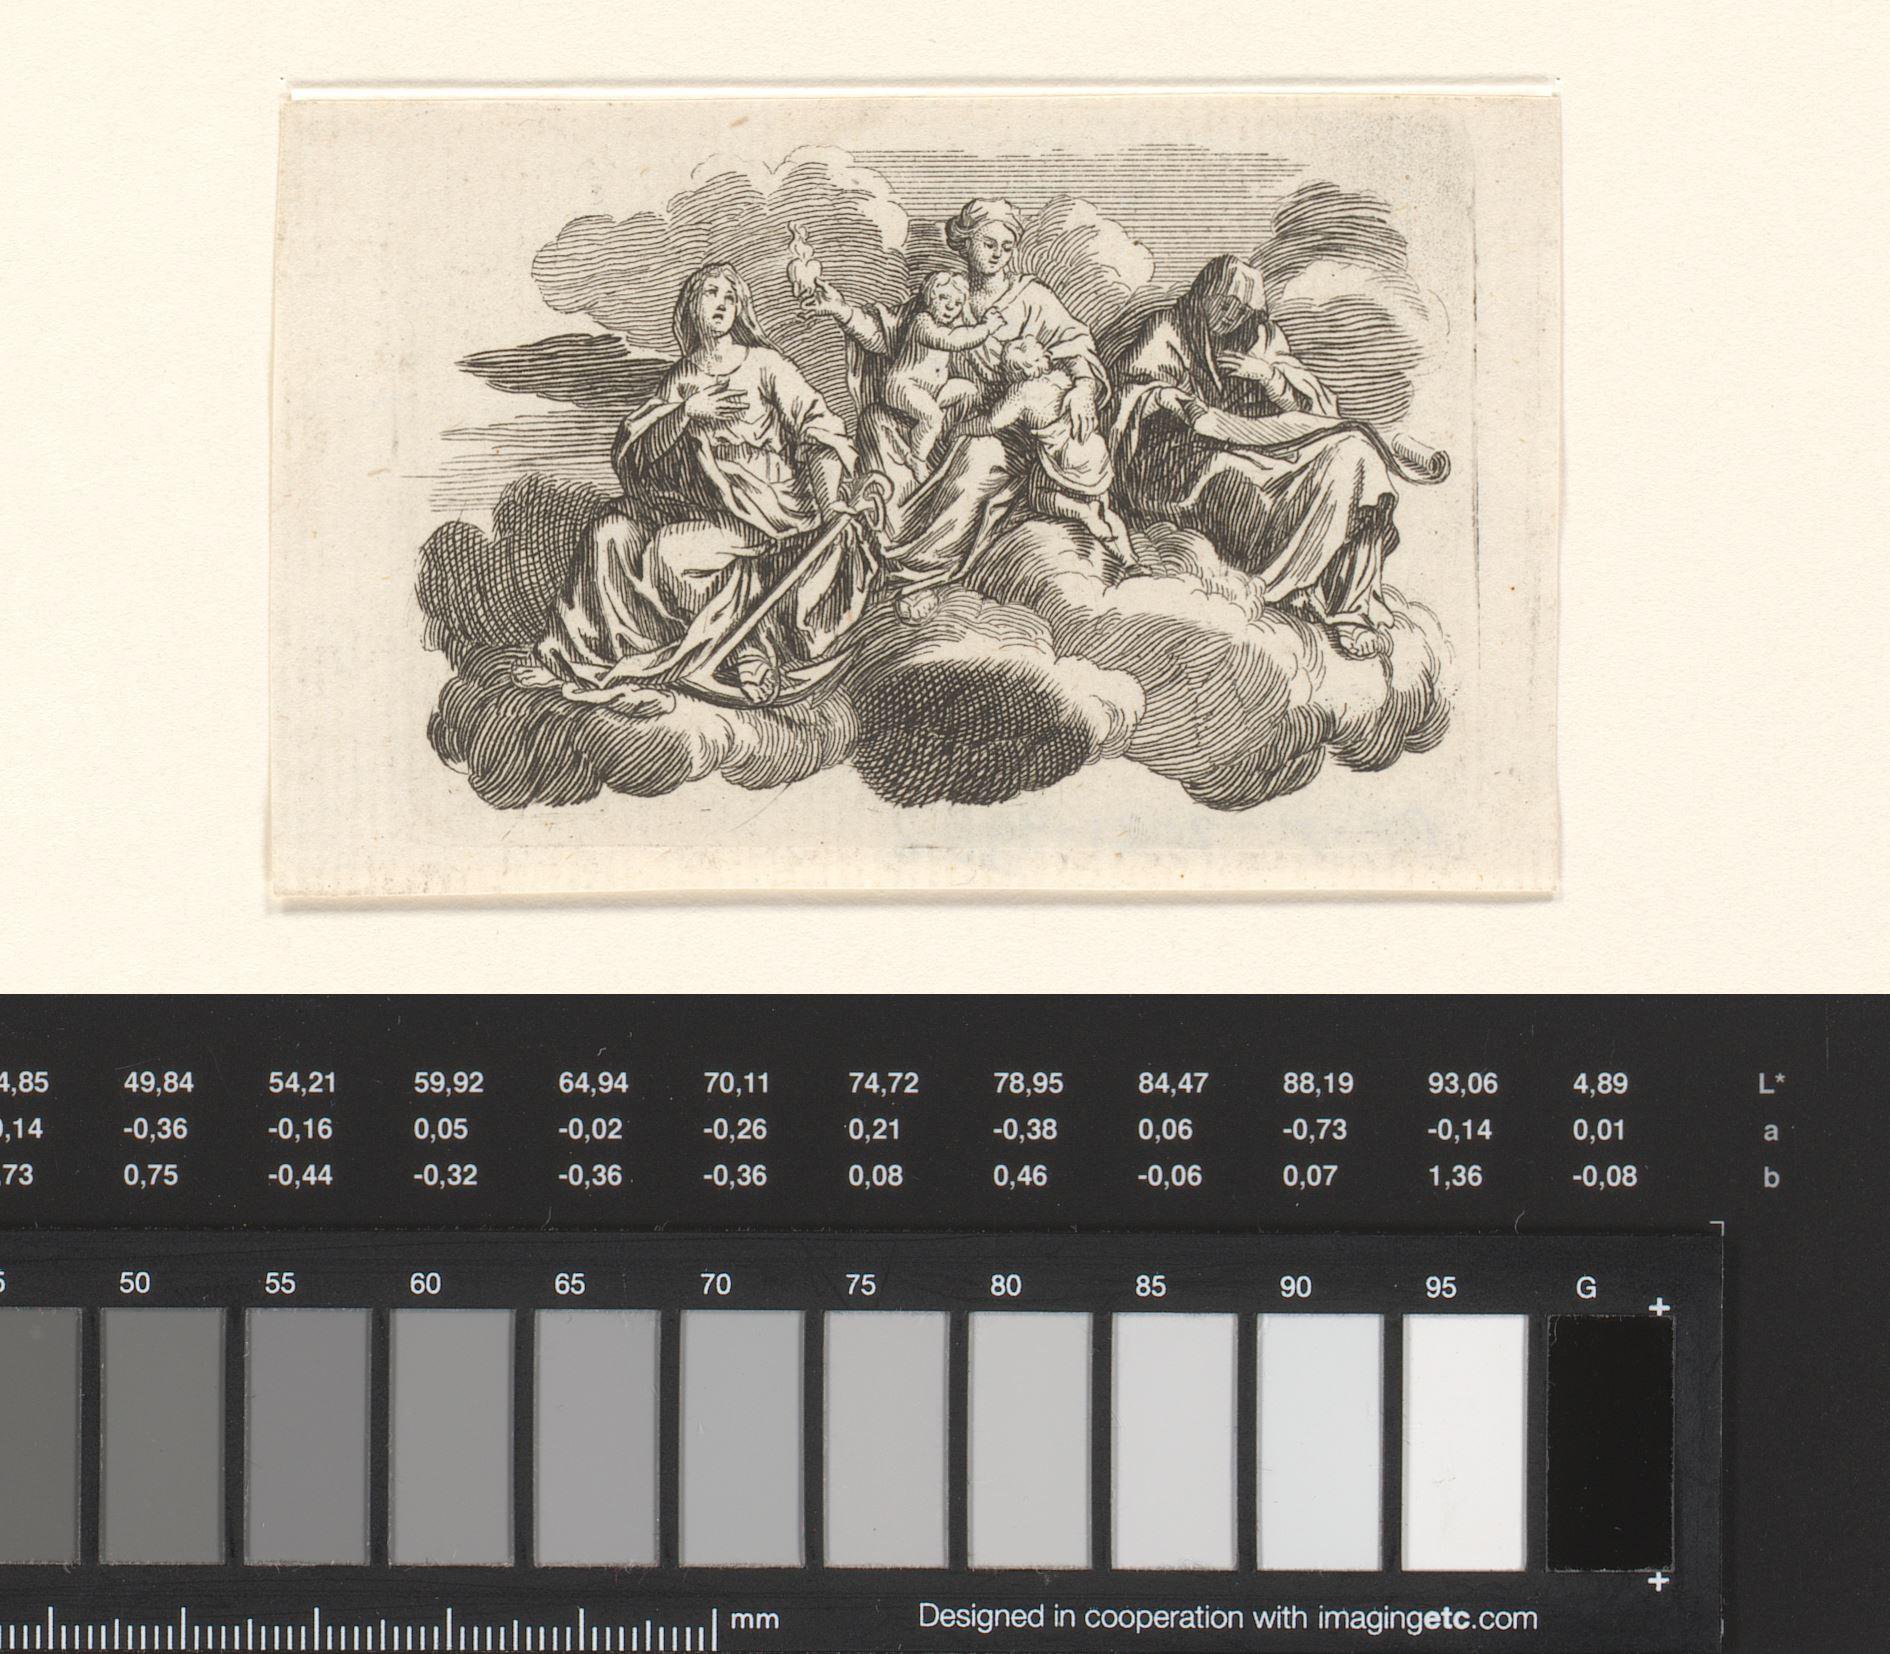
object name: print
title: Drie goddelijke deugden op een wolk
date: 1717-1767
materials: paper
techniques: etching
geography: netherlands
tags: the three theological virtues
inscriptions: collector's mark: Lugt 2228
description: Van links naar rechts: Hoop, Liefde en Geloof.